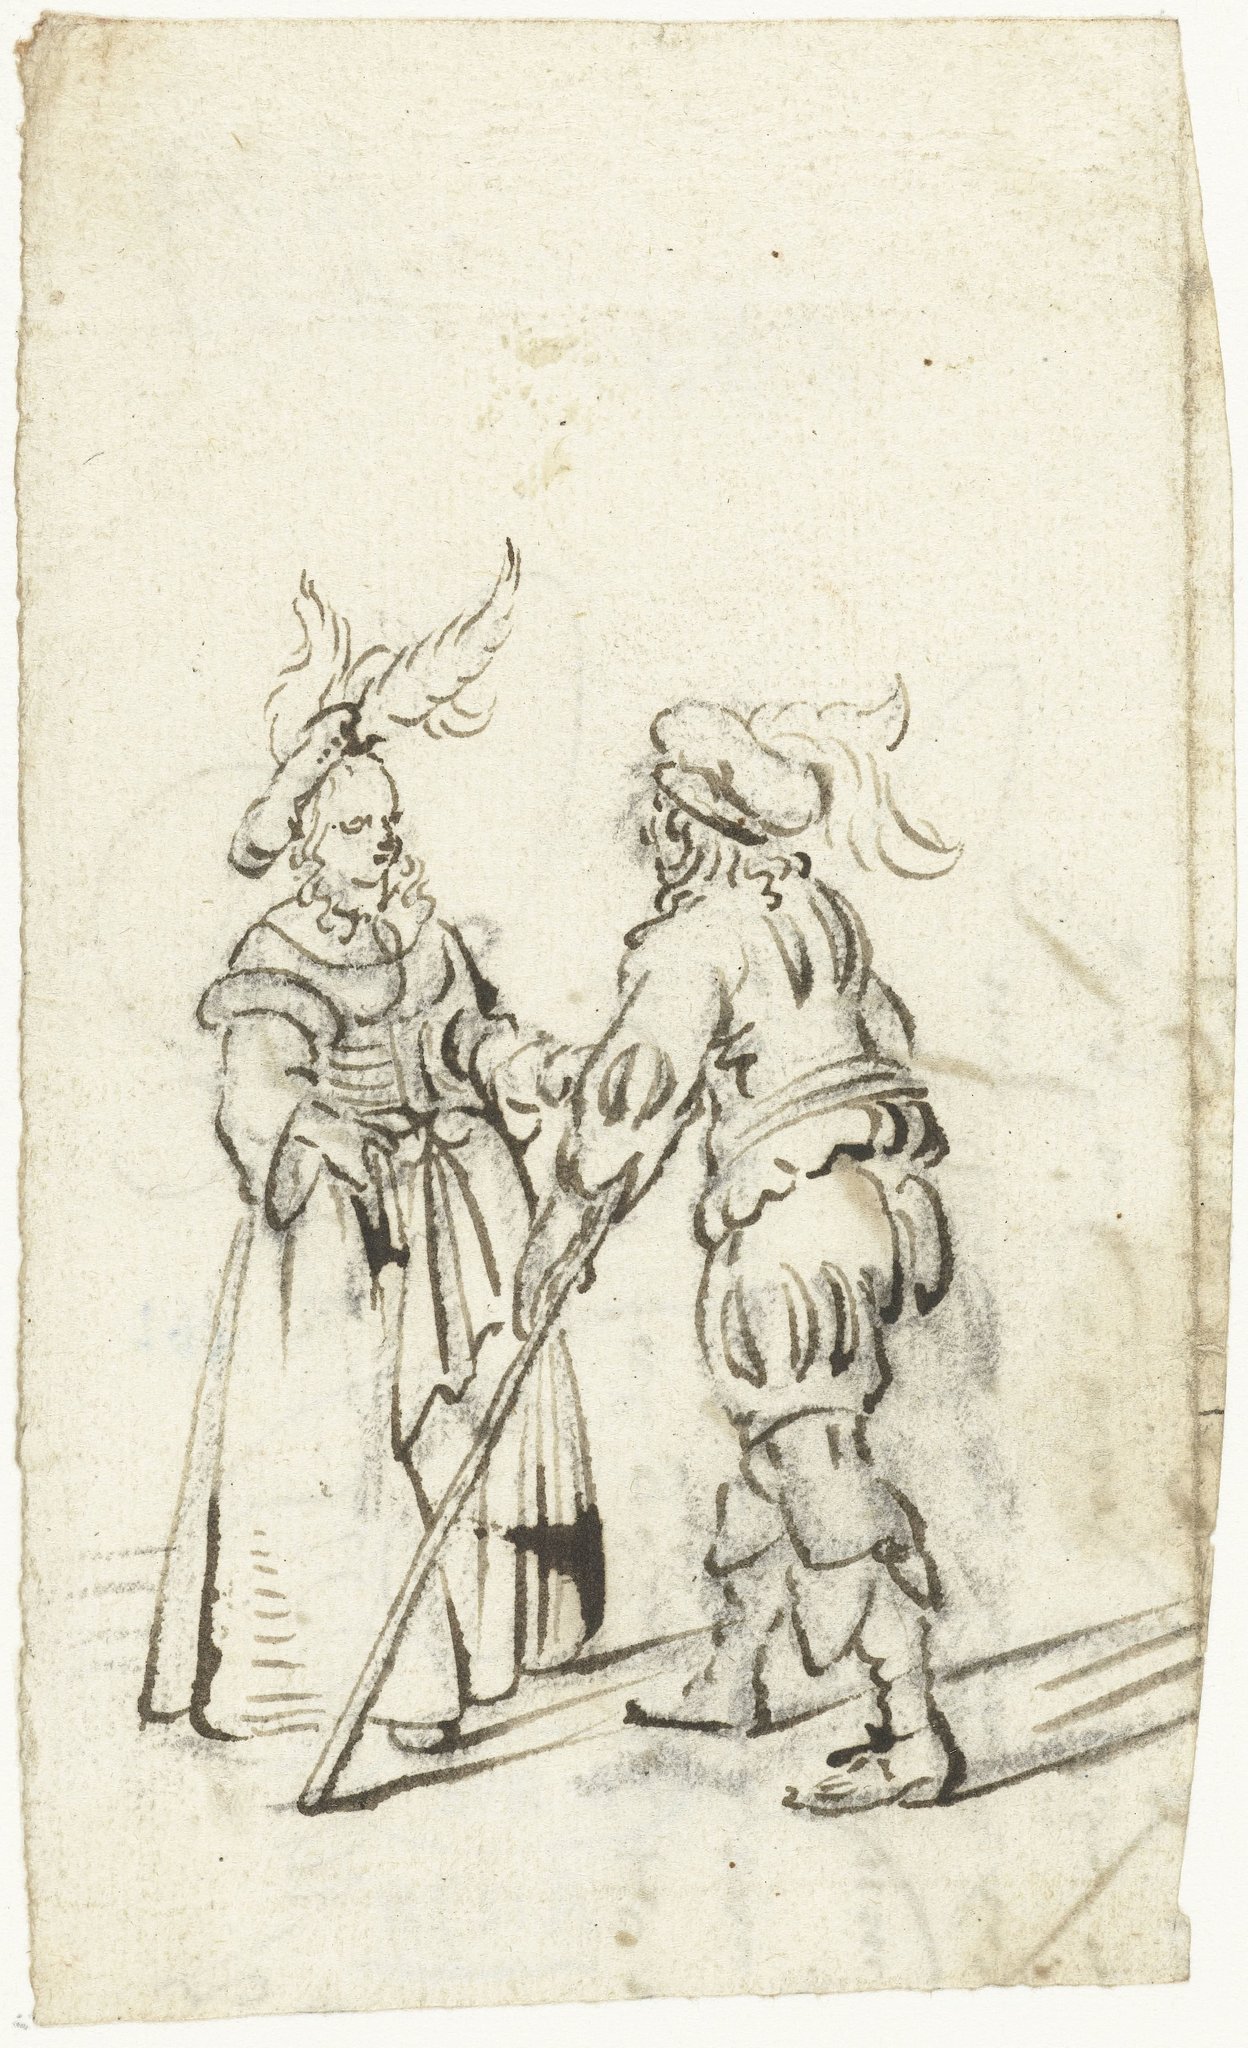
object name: drawing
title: Staand stel in kostuum, met elkaar in gesprek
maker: harmen ter borch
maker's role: draughtsman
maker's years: 1638-1677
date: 1654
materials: chalk, ink, paper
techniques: brush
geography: zwolle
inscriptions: inscription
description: Voorstudie voor een illustratie in het Poëziealbum, folio 49.